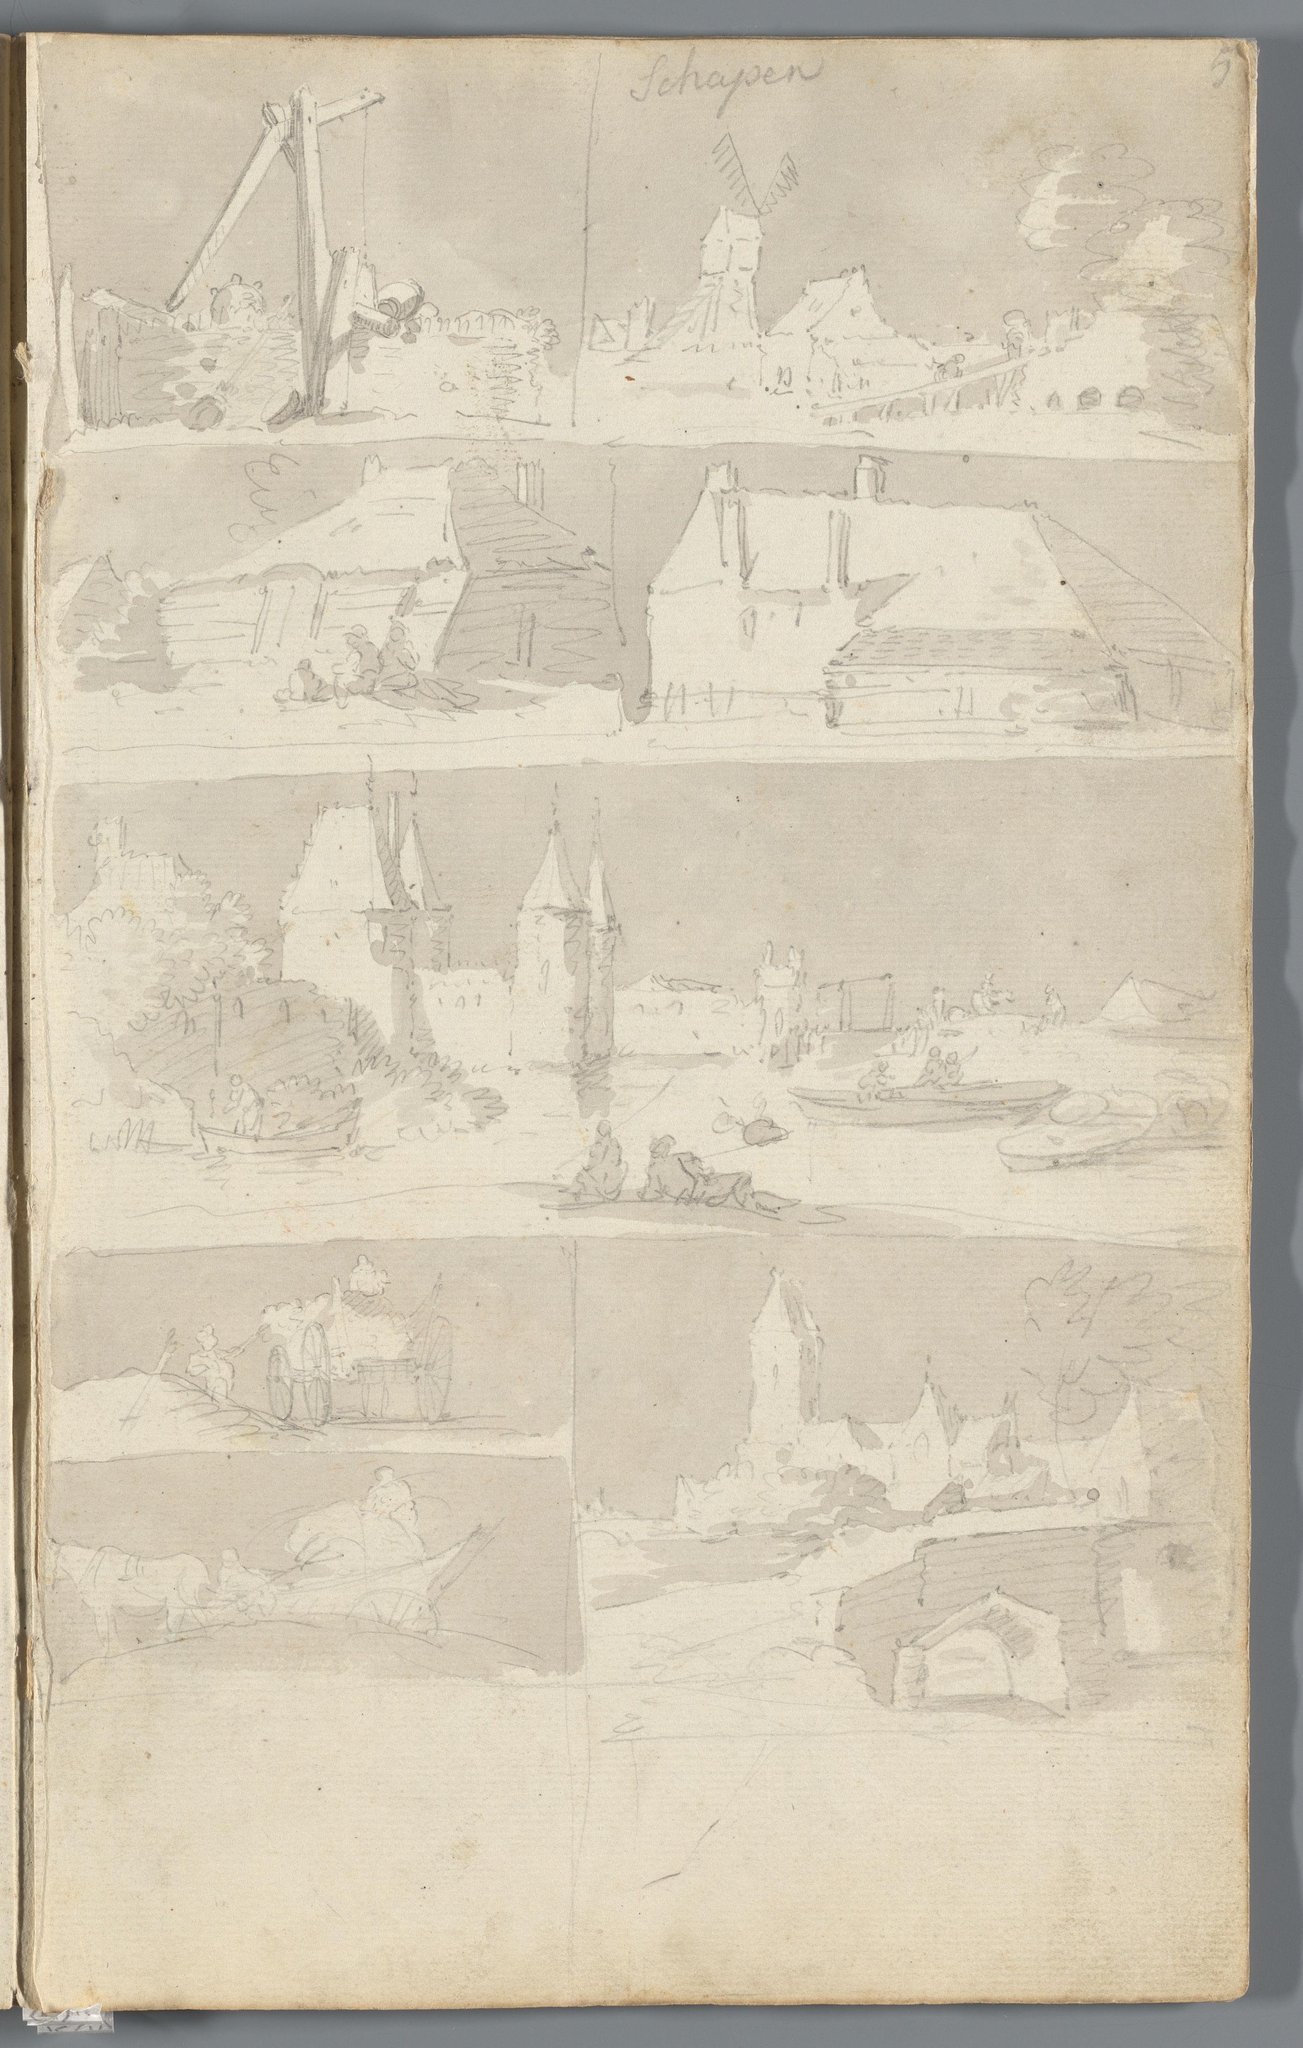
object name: sketchbook leaf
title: Stadsgezichten en boeren hoeves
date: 1780-1800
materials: ink, paper, pencil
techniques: brush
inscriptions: inscription: ‘Schapen’, inscription: ‘5’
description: Blad 3 recto uit een schetsboek met 17 bladen.